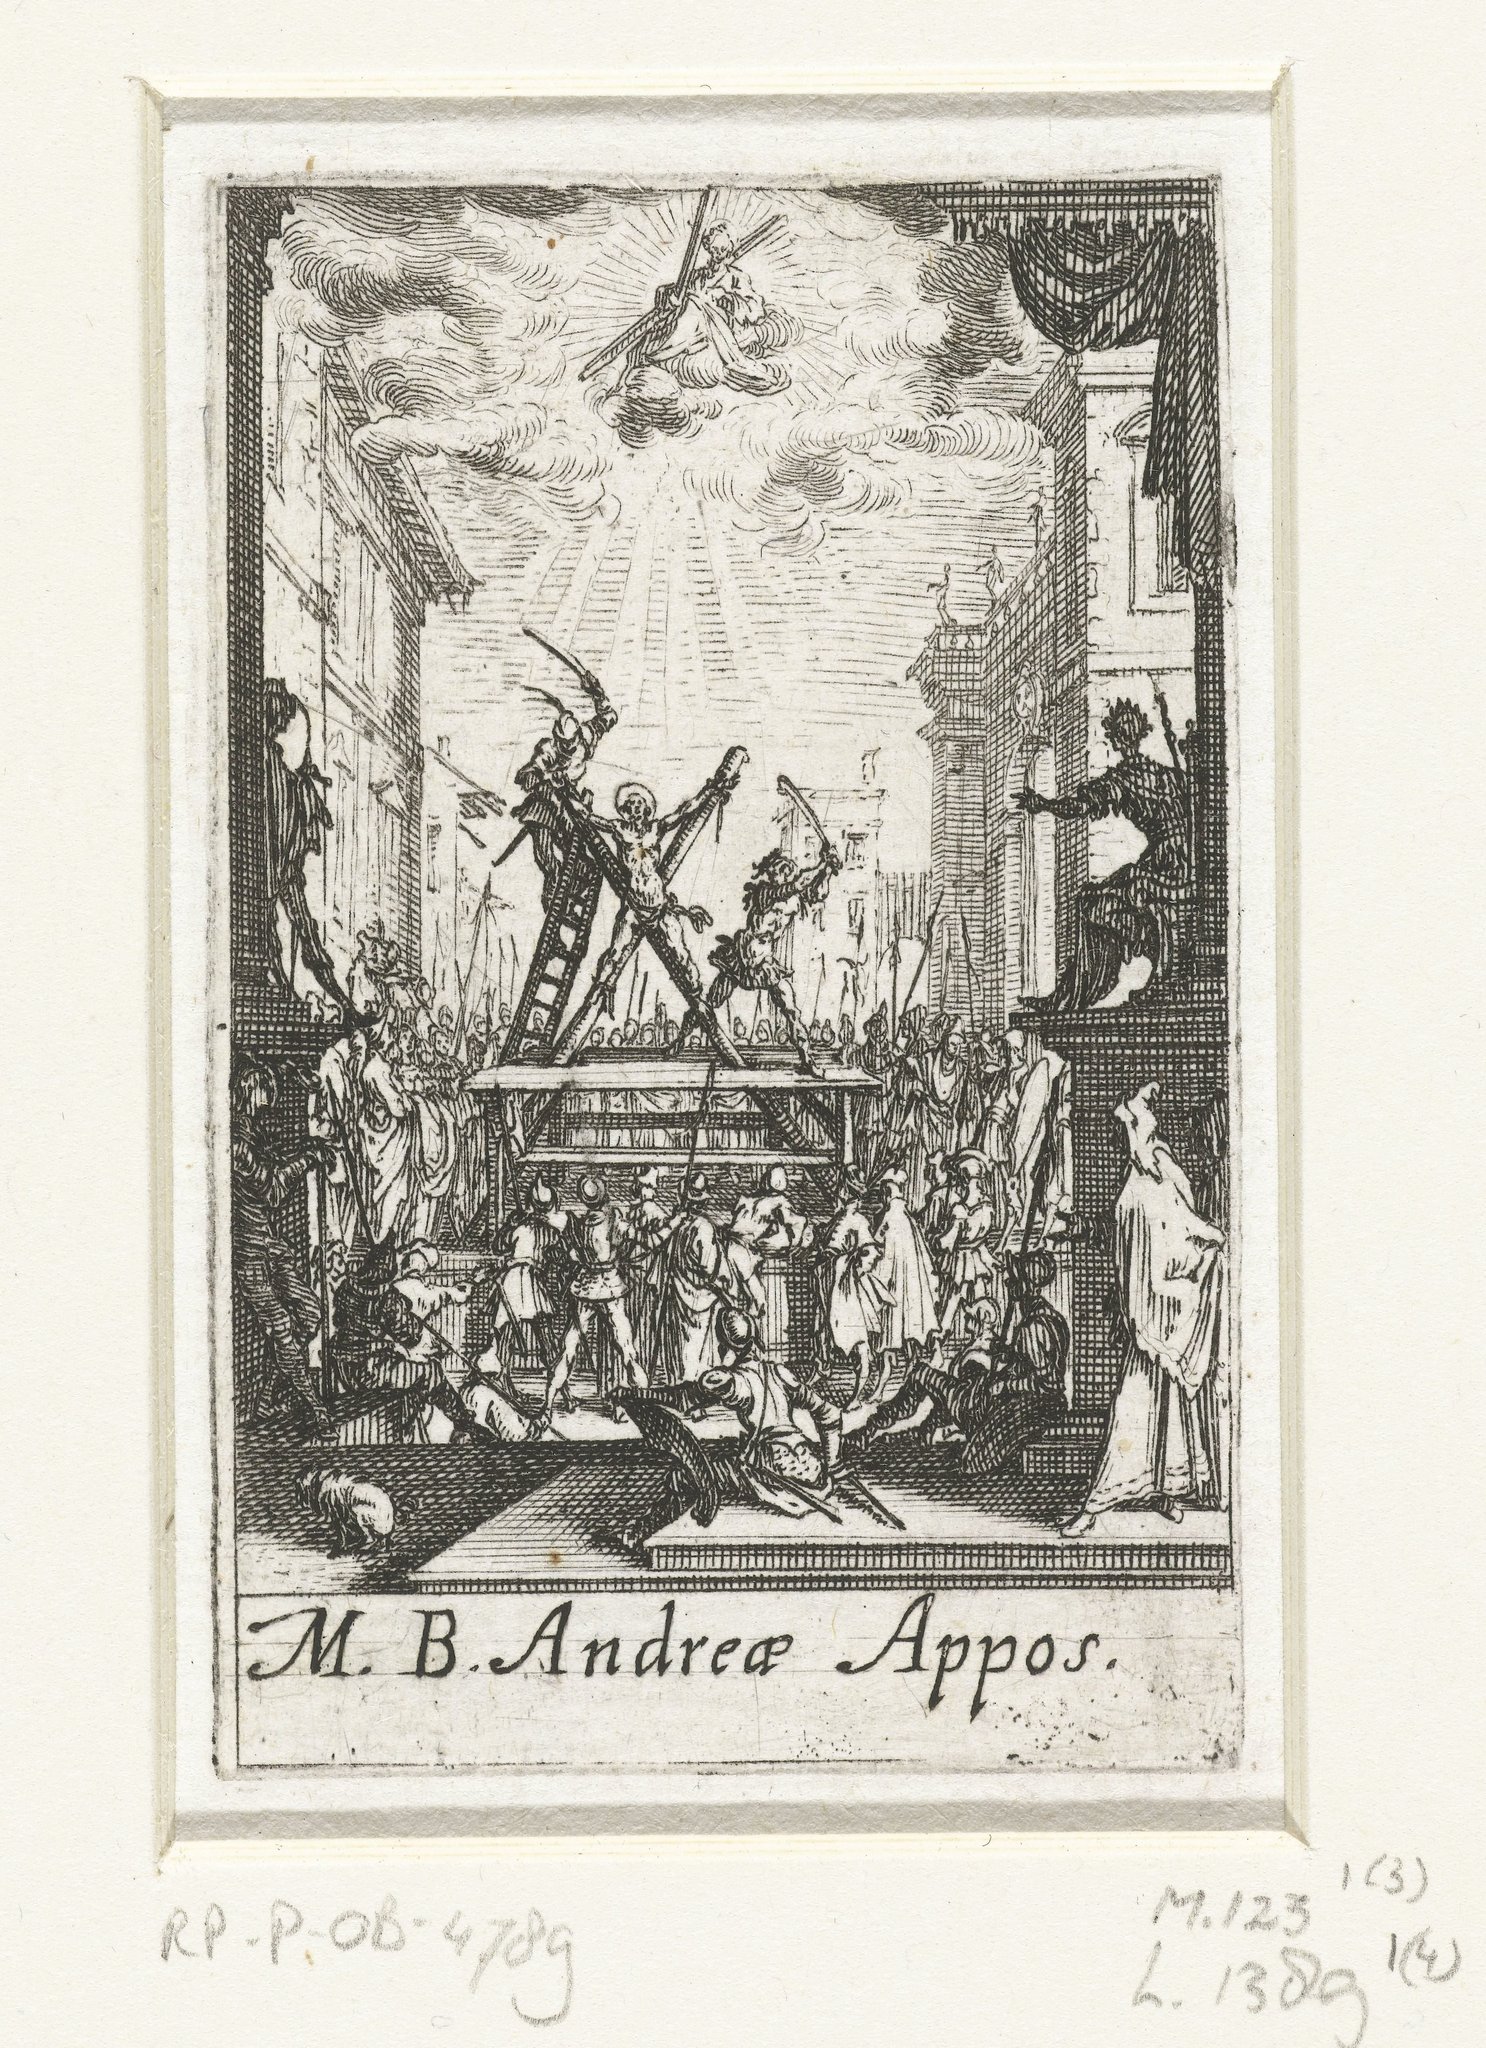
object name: print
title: Het martelaarschap van Andreas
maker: jacques callot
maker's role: draughtsman, print maker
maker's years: 1592-1635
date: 1632-1634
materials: paper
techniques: etching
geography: nancy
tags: crucifixion of andrew: he is undressed and tied to the cross, the apostle andrew; possible attributes: book, x-shaped cross, fish, fishing-net, rope, scroll - martyrdom, suffering, misfortune, death of male saint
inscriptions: collector's mark: Lugt 240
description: Andreas wordt gekruisigd op een X-vormig kruis in het bijzijn van vele toeschouwers. Boven deze scène is Andreas nogmaals afgebeeld, op een wolk in de hemel, een gekanteld kruis in de handen. Onder de voorstelling een onderschrift in Latijn. Deze prent is onderdeel van een reeks van 16 prenten, bestaande uit een titelblad en 15 voorstellingen van de martelingen die de apostelen hebben ondergaan.